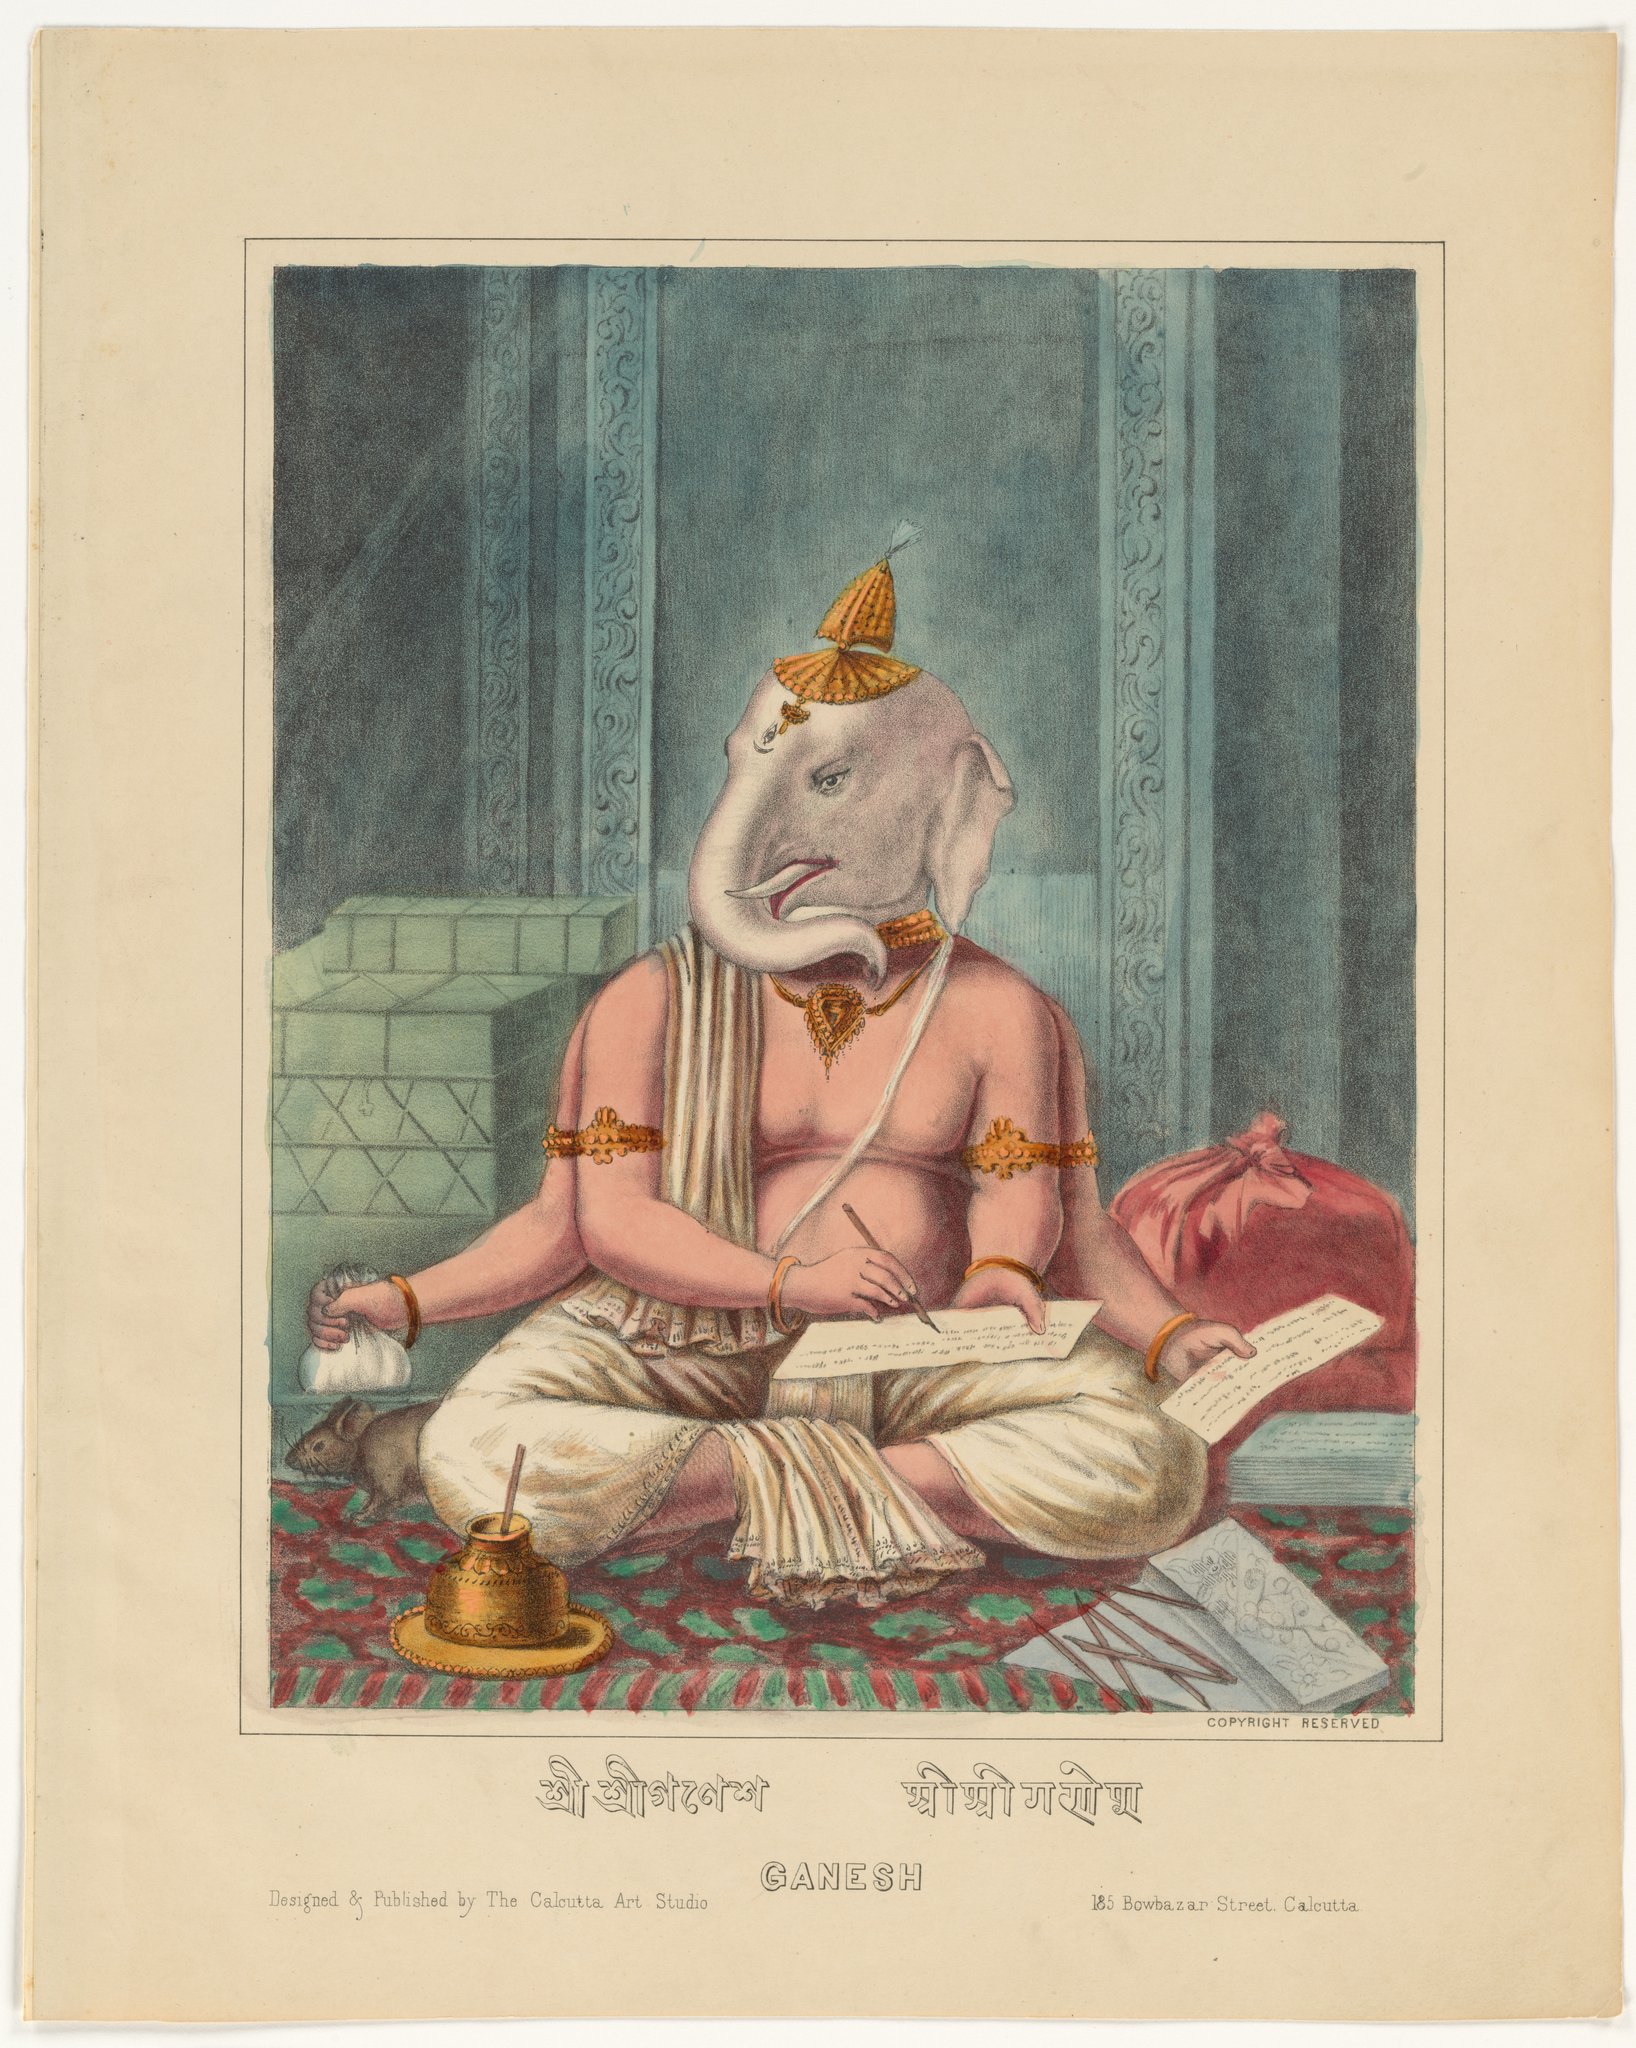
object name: lithograph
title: Ganesha Transcribing the Mahabharata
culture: indian or west bengali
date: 1878-1883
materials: glaze, watercolor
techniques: hand coloring, lithograph, printing